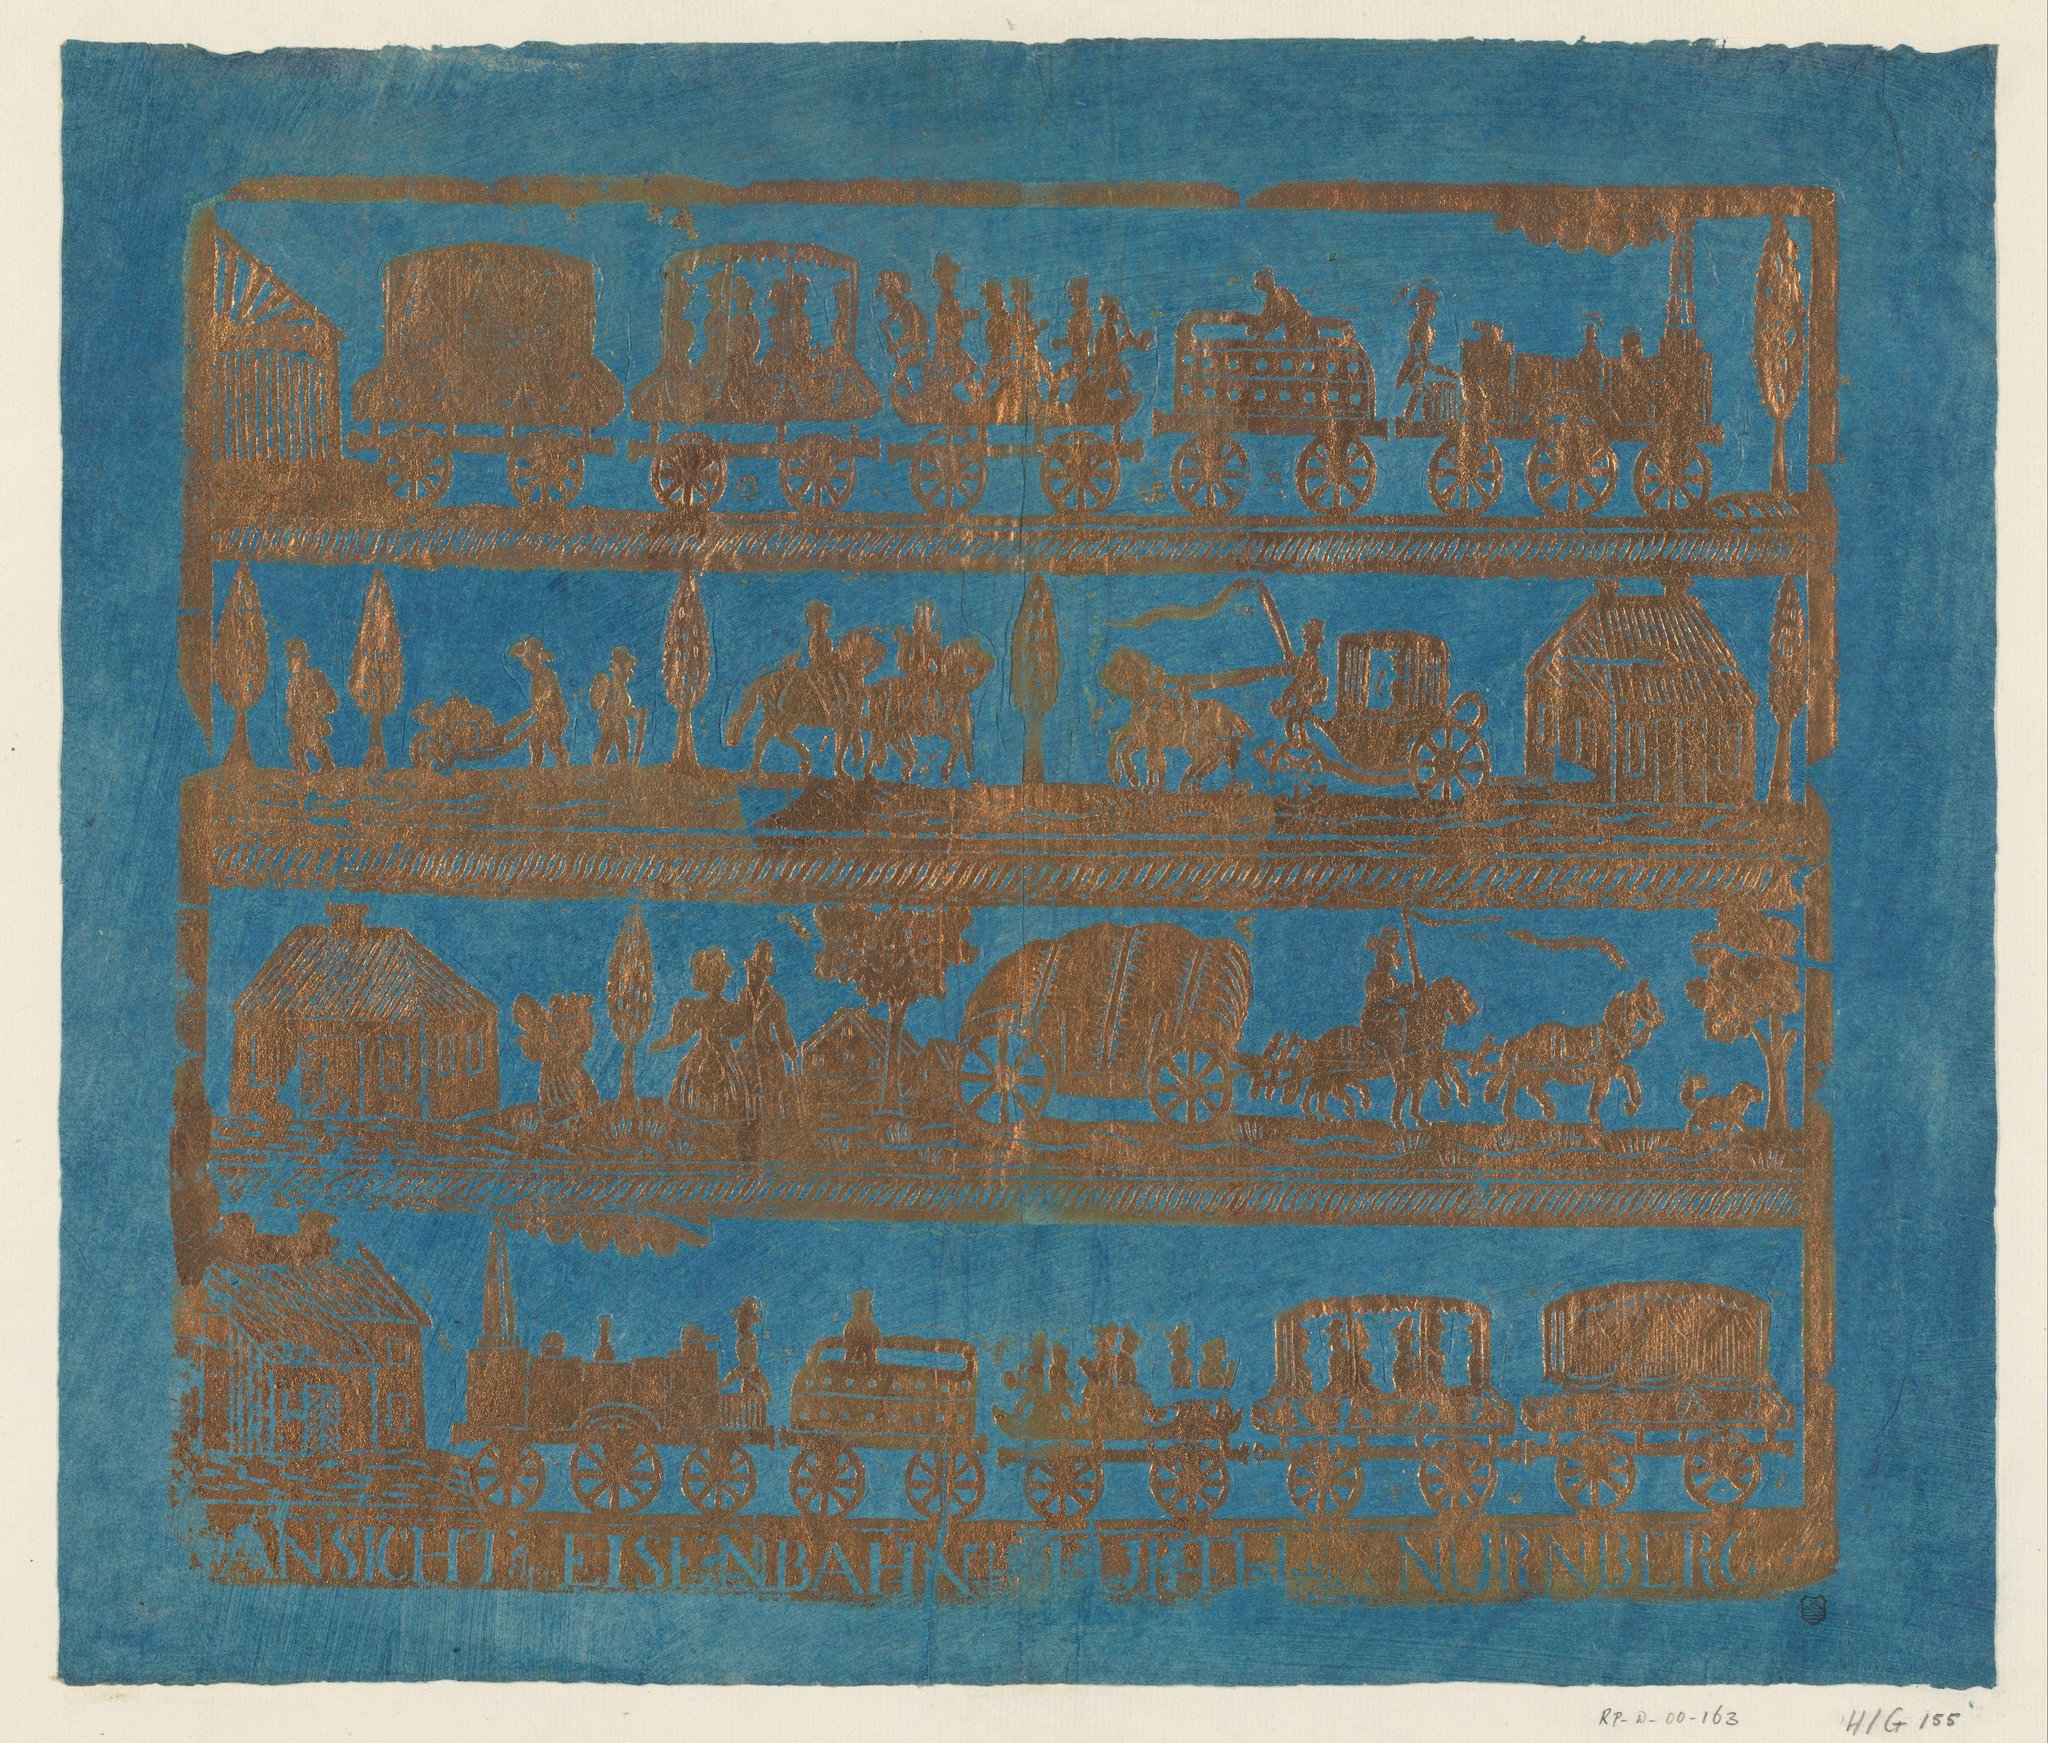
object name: brocade paper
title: Ansicht Eisenbahn Fürth Nurnberg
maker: Anonymous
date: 1830-1835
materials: gold leaf, paint, paper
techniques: relief print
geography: nuremberg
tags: animal traction, animal-drawn vehicle (carriage etc.), railway, train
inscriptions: collector's mark: Lugt 2760, collector's mark: Lugt 2228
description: Blad met vier rijen met vervoermiddelen, bovenste en onderste rij spoorwegen met treinen. Spoorlijn tussen Neurenberg en Fürth.